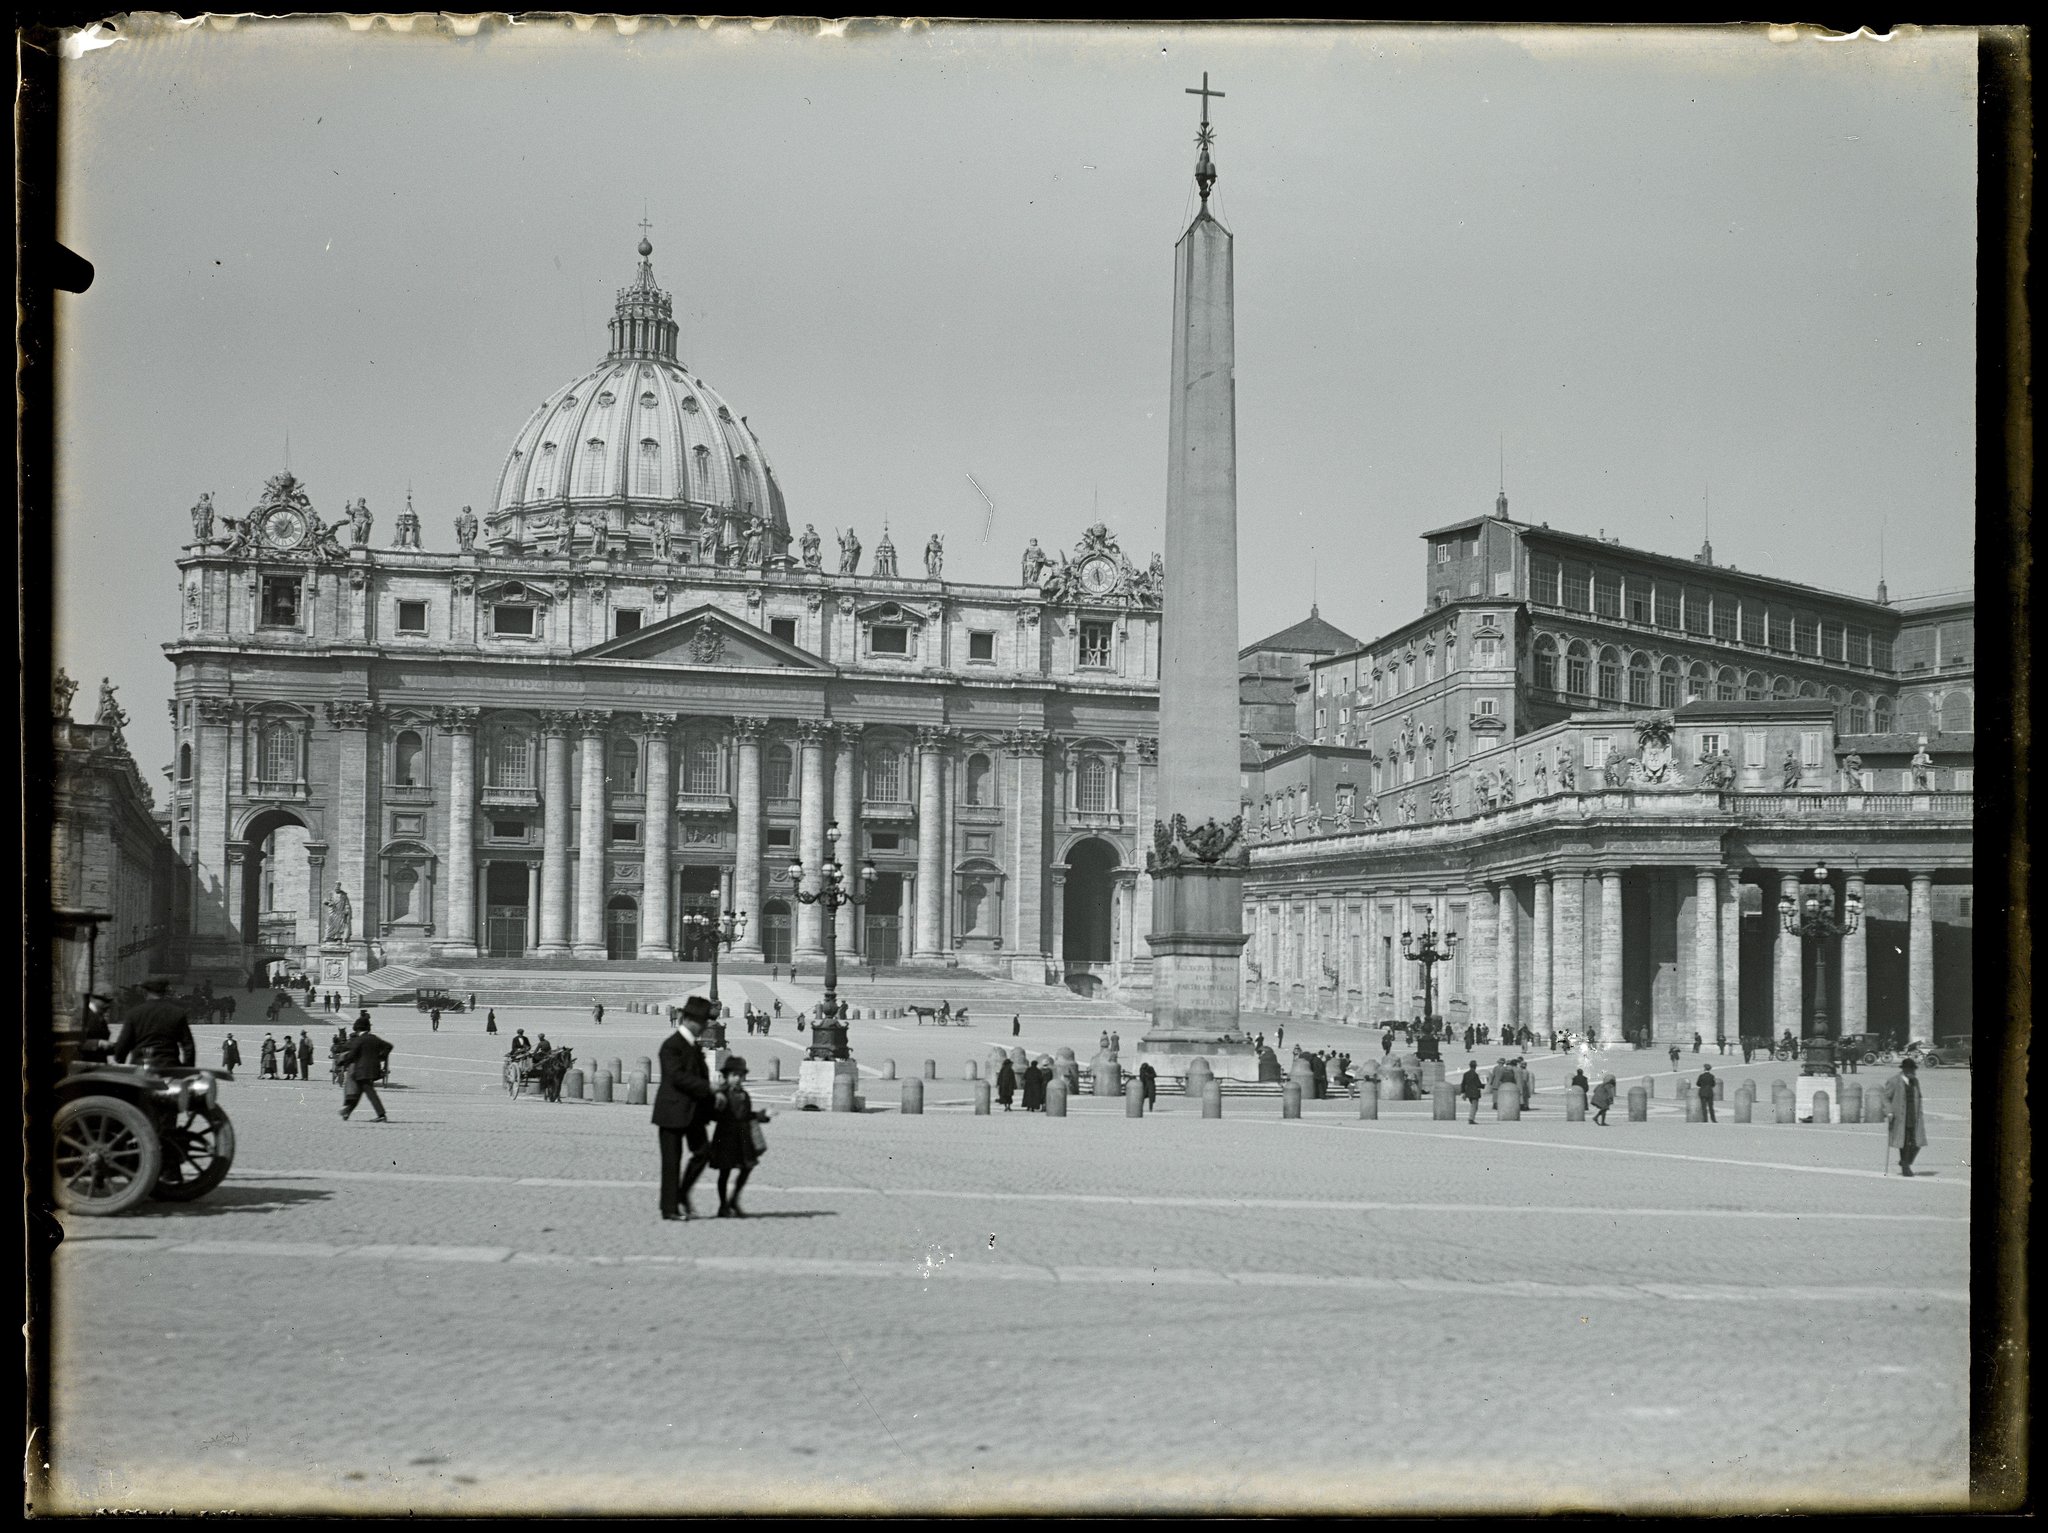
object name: glasnegatief, glasplaatnegatief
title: Sint-Pietersplein met de Sint-Pietersbasiliek, de Vaticaanse Obelisk en de colonnade, Vaticaanstad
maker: Anonymous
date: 1907-1935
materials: glass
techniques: gelatin glass negative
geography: vatican city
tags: square, place, circus, etc., obelisk, needle, roman catholic church